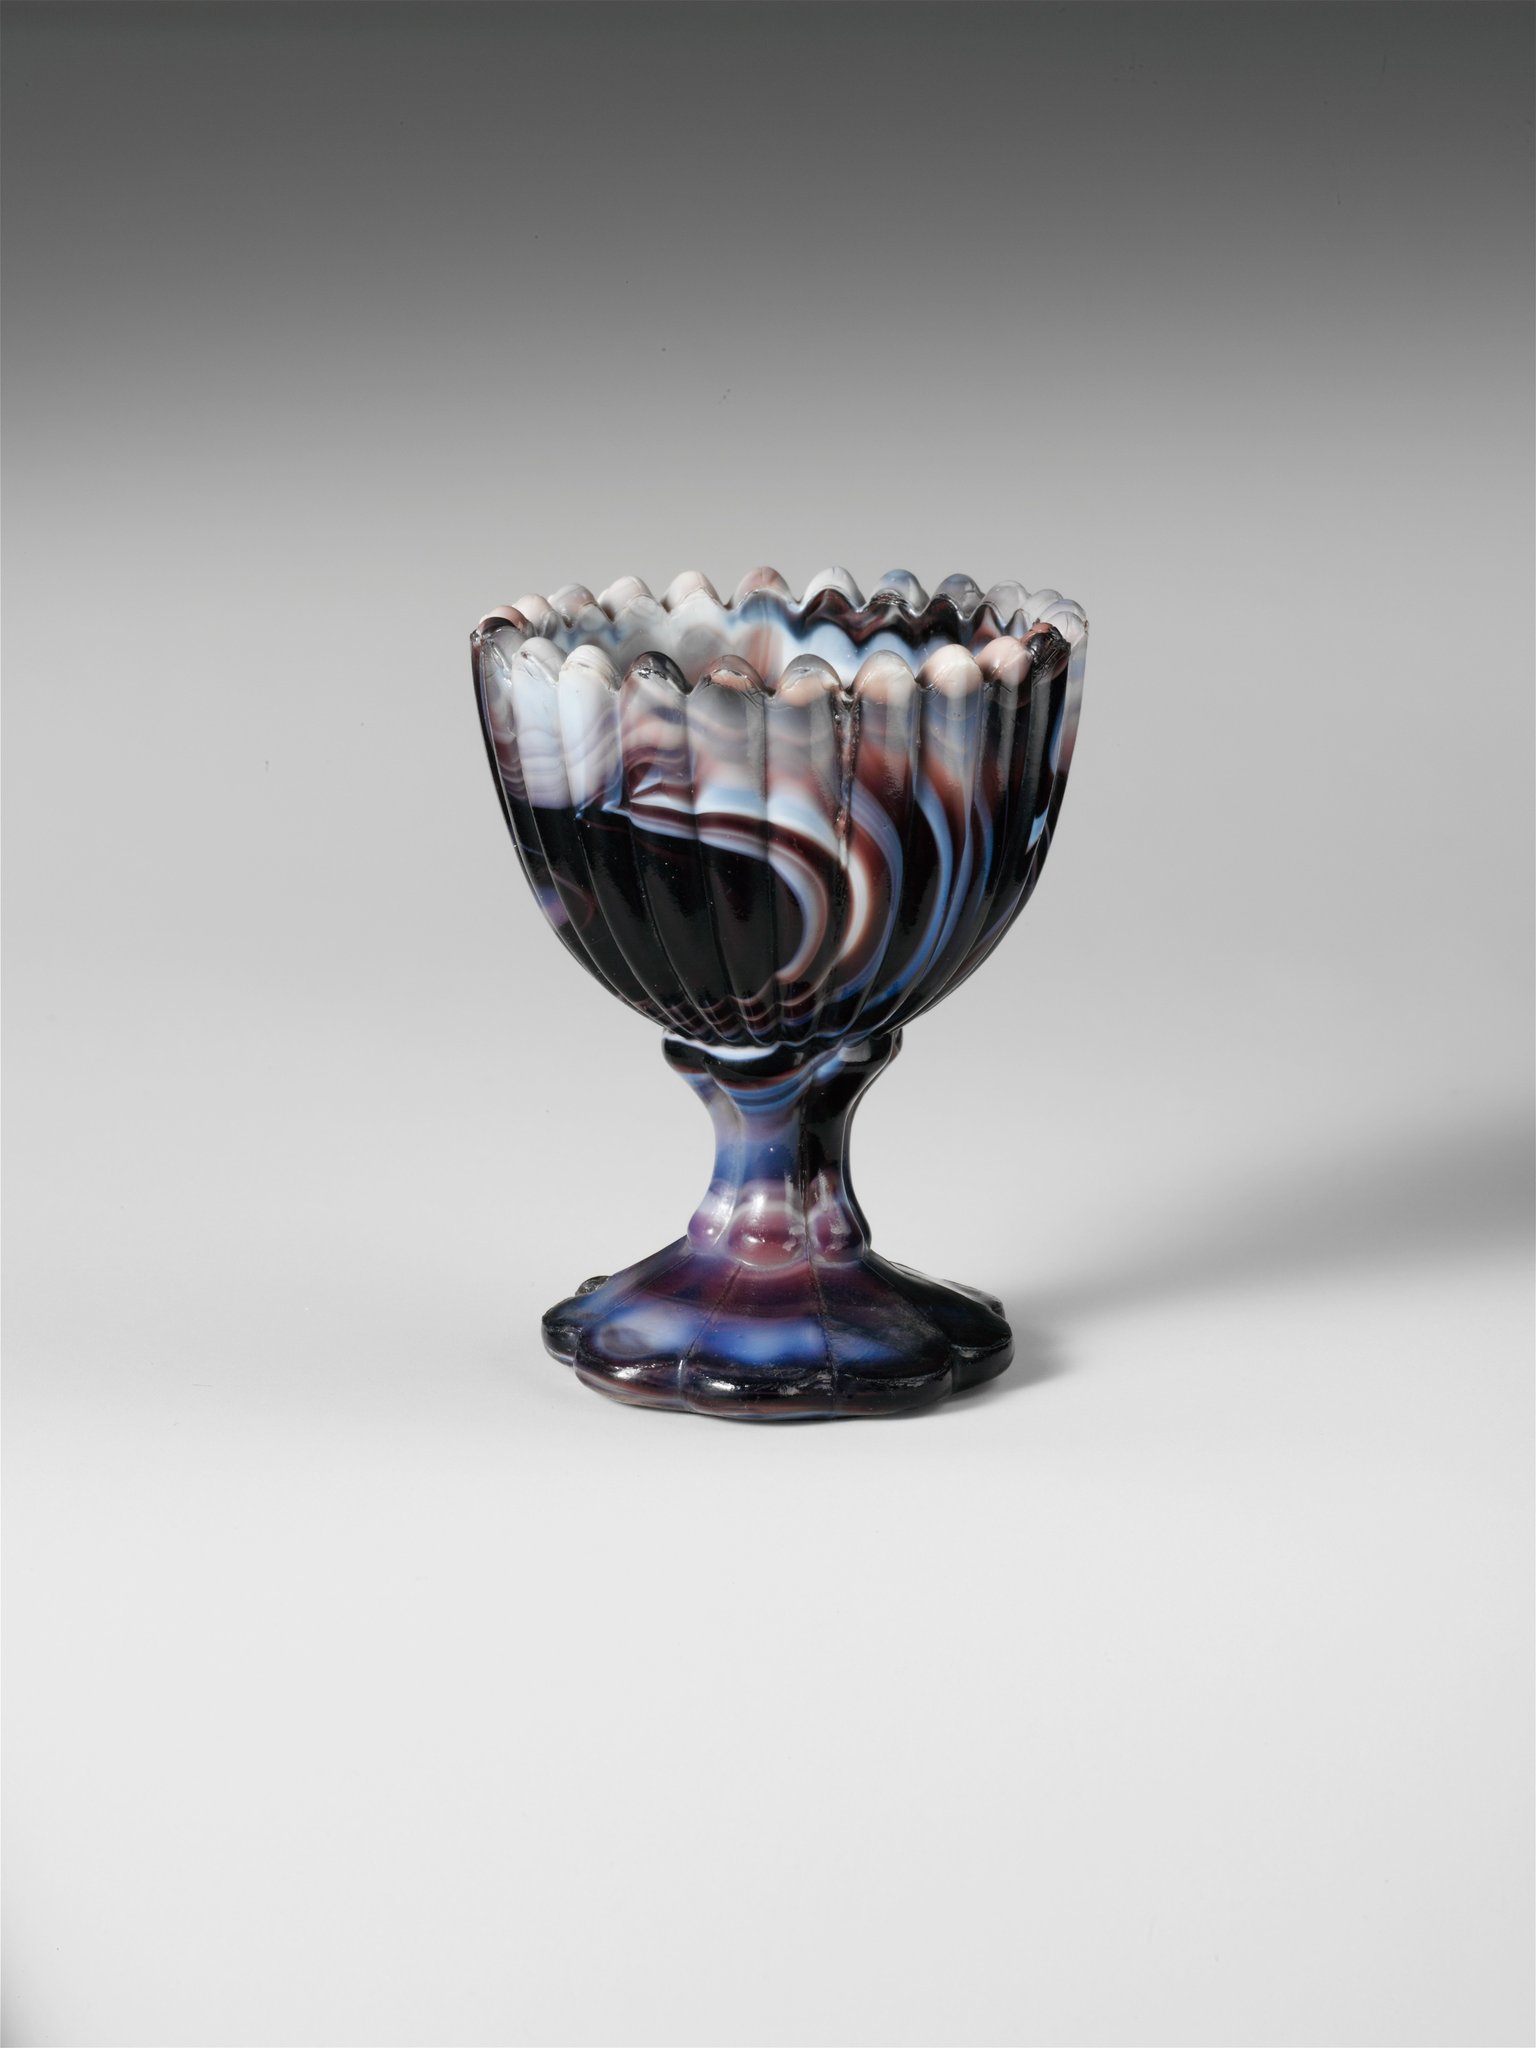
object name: egg cup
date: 1880-1890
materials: glass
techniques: pressed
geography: england